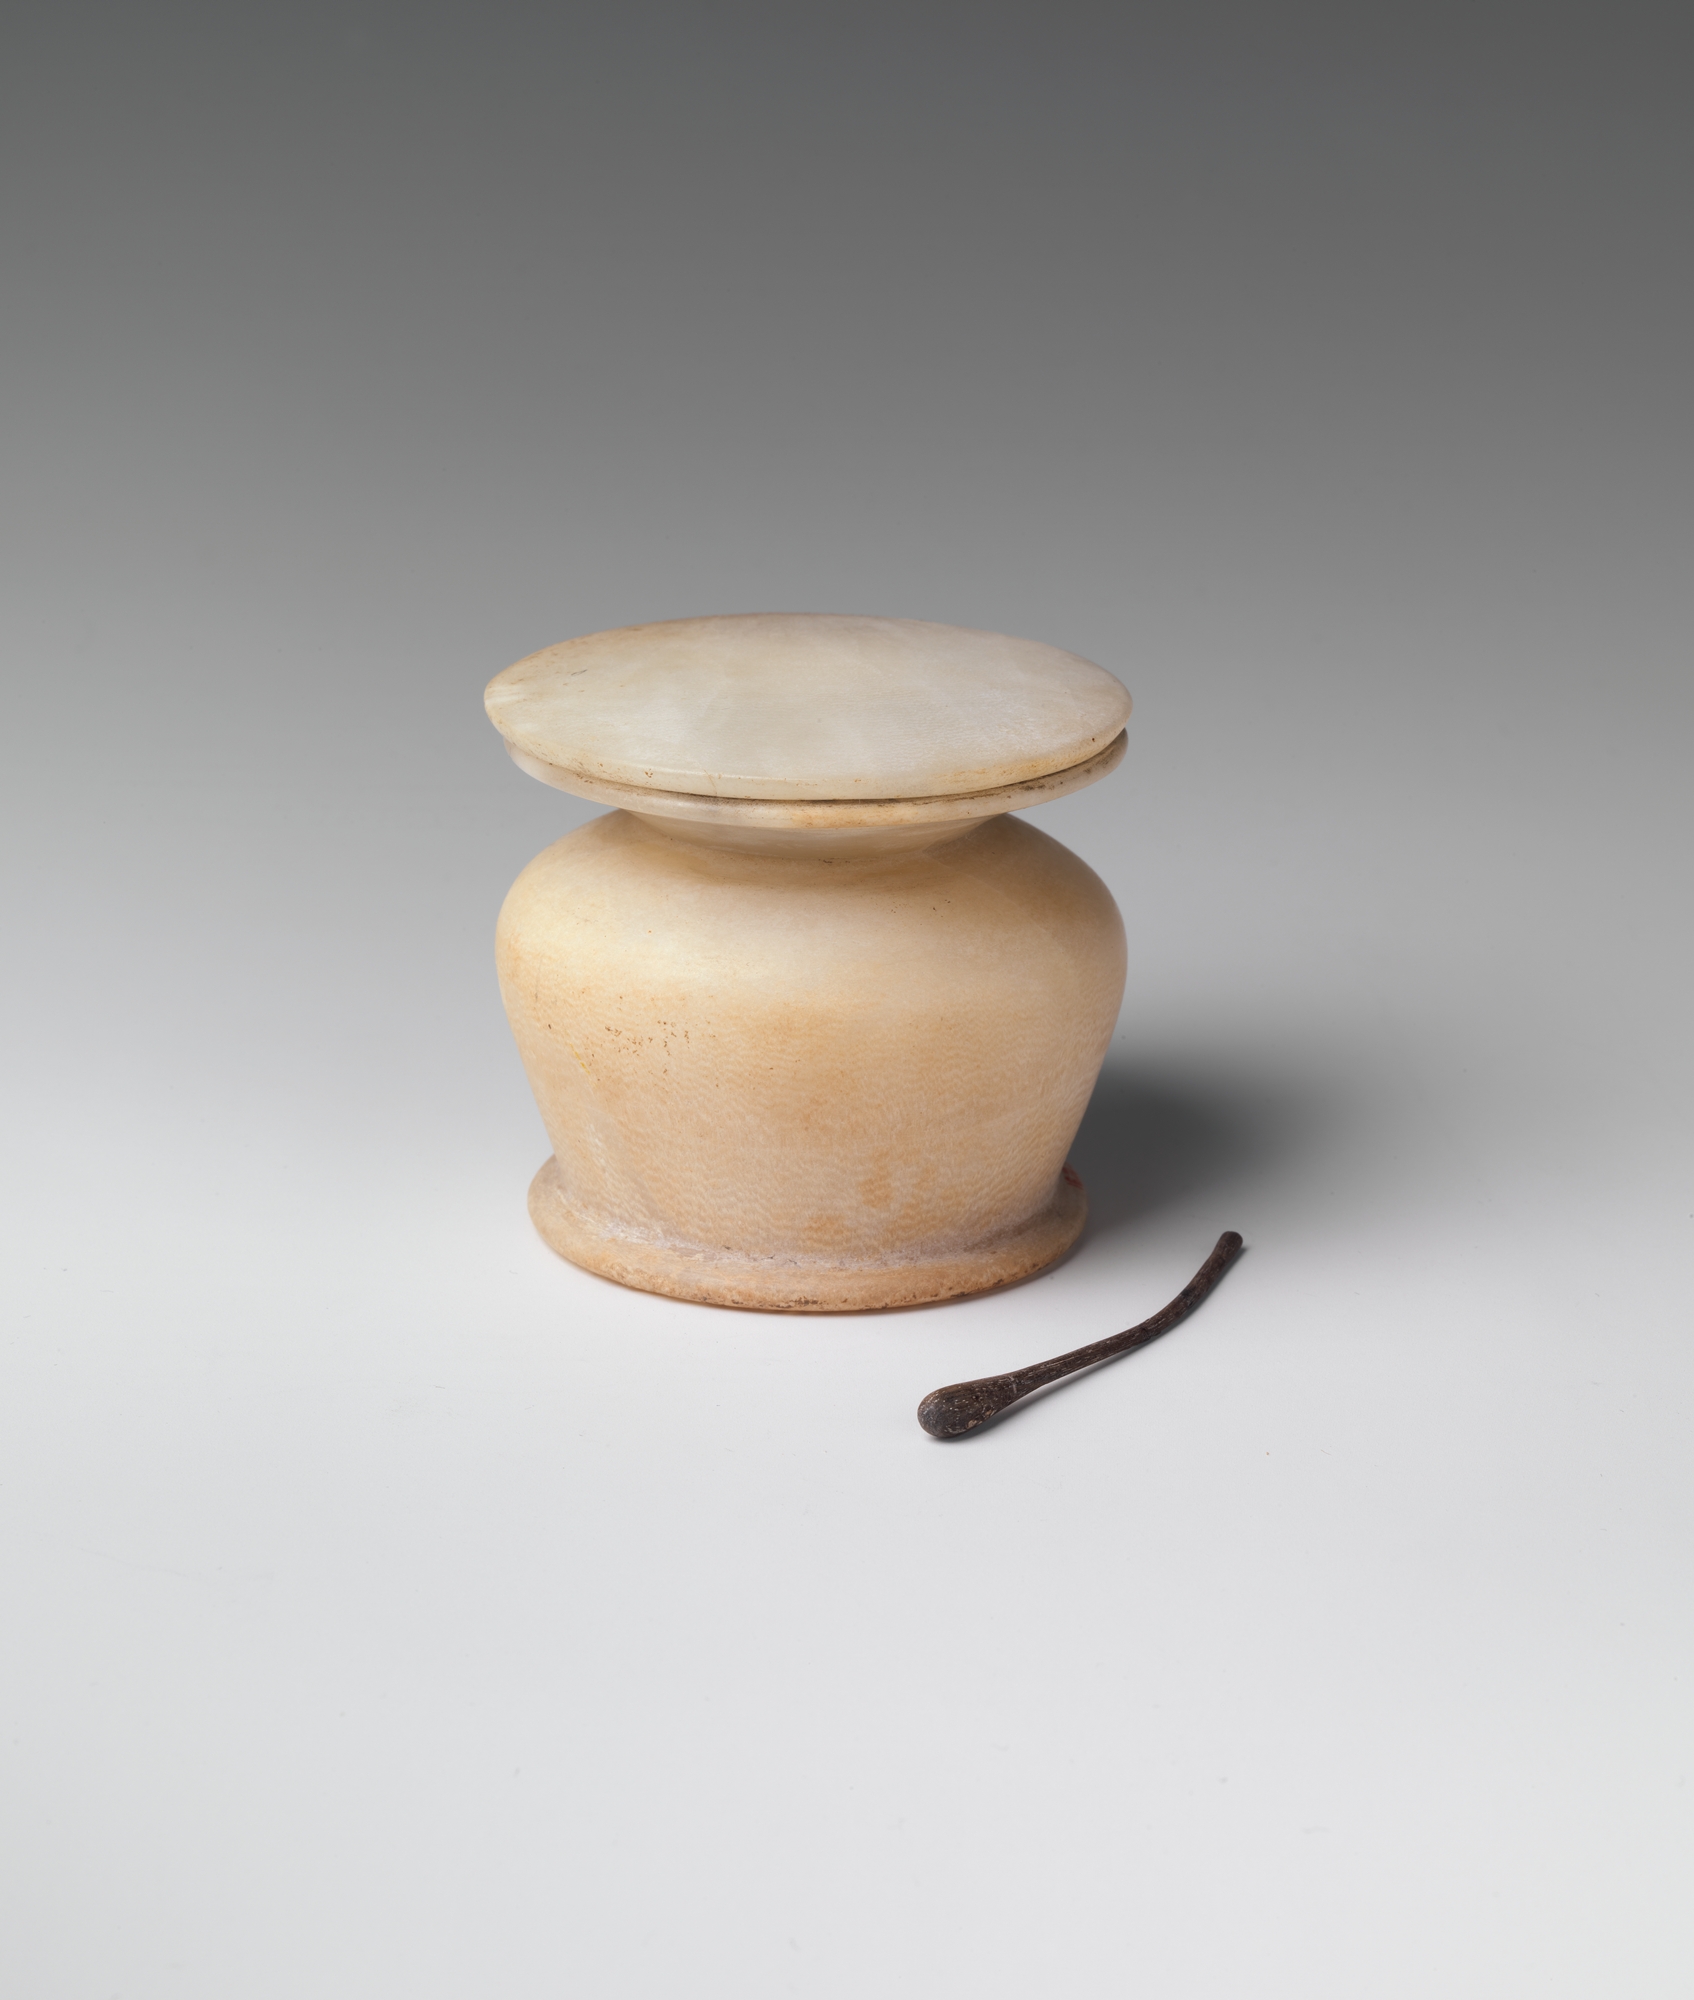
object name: kohl jar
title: Kohl Jar and Stick (with 16.10.373a, b)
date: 1635-1458 BCE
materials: wood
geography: egypt